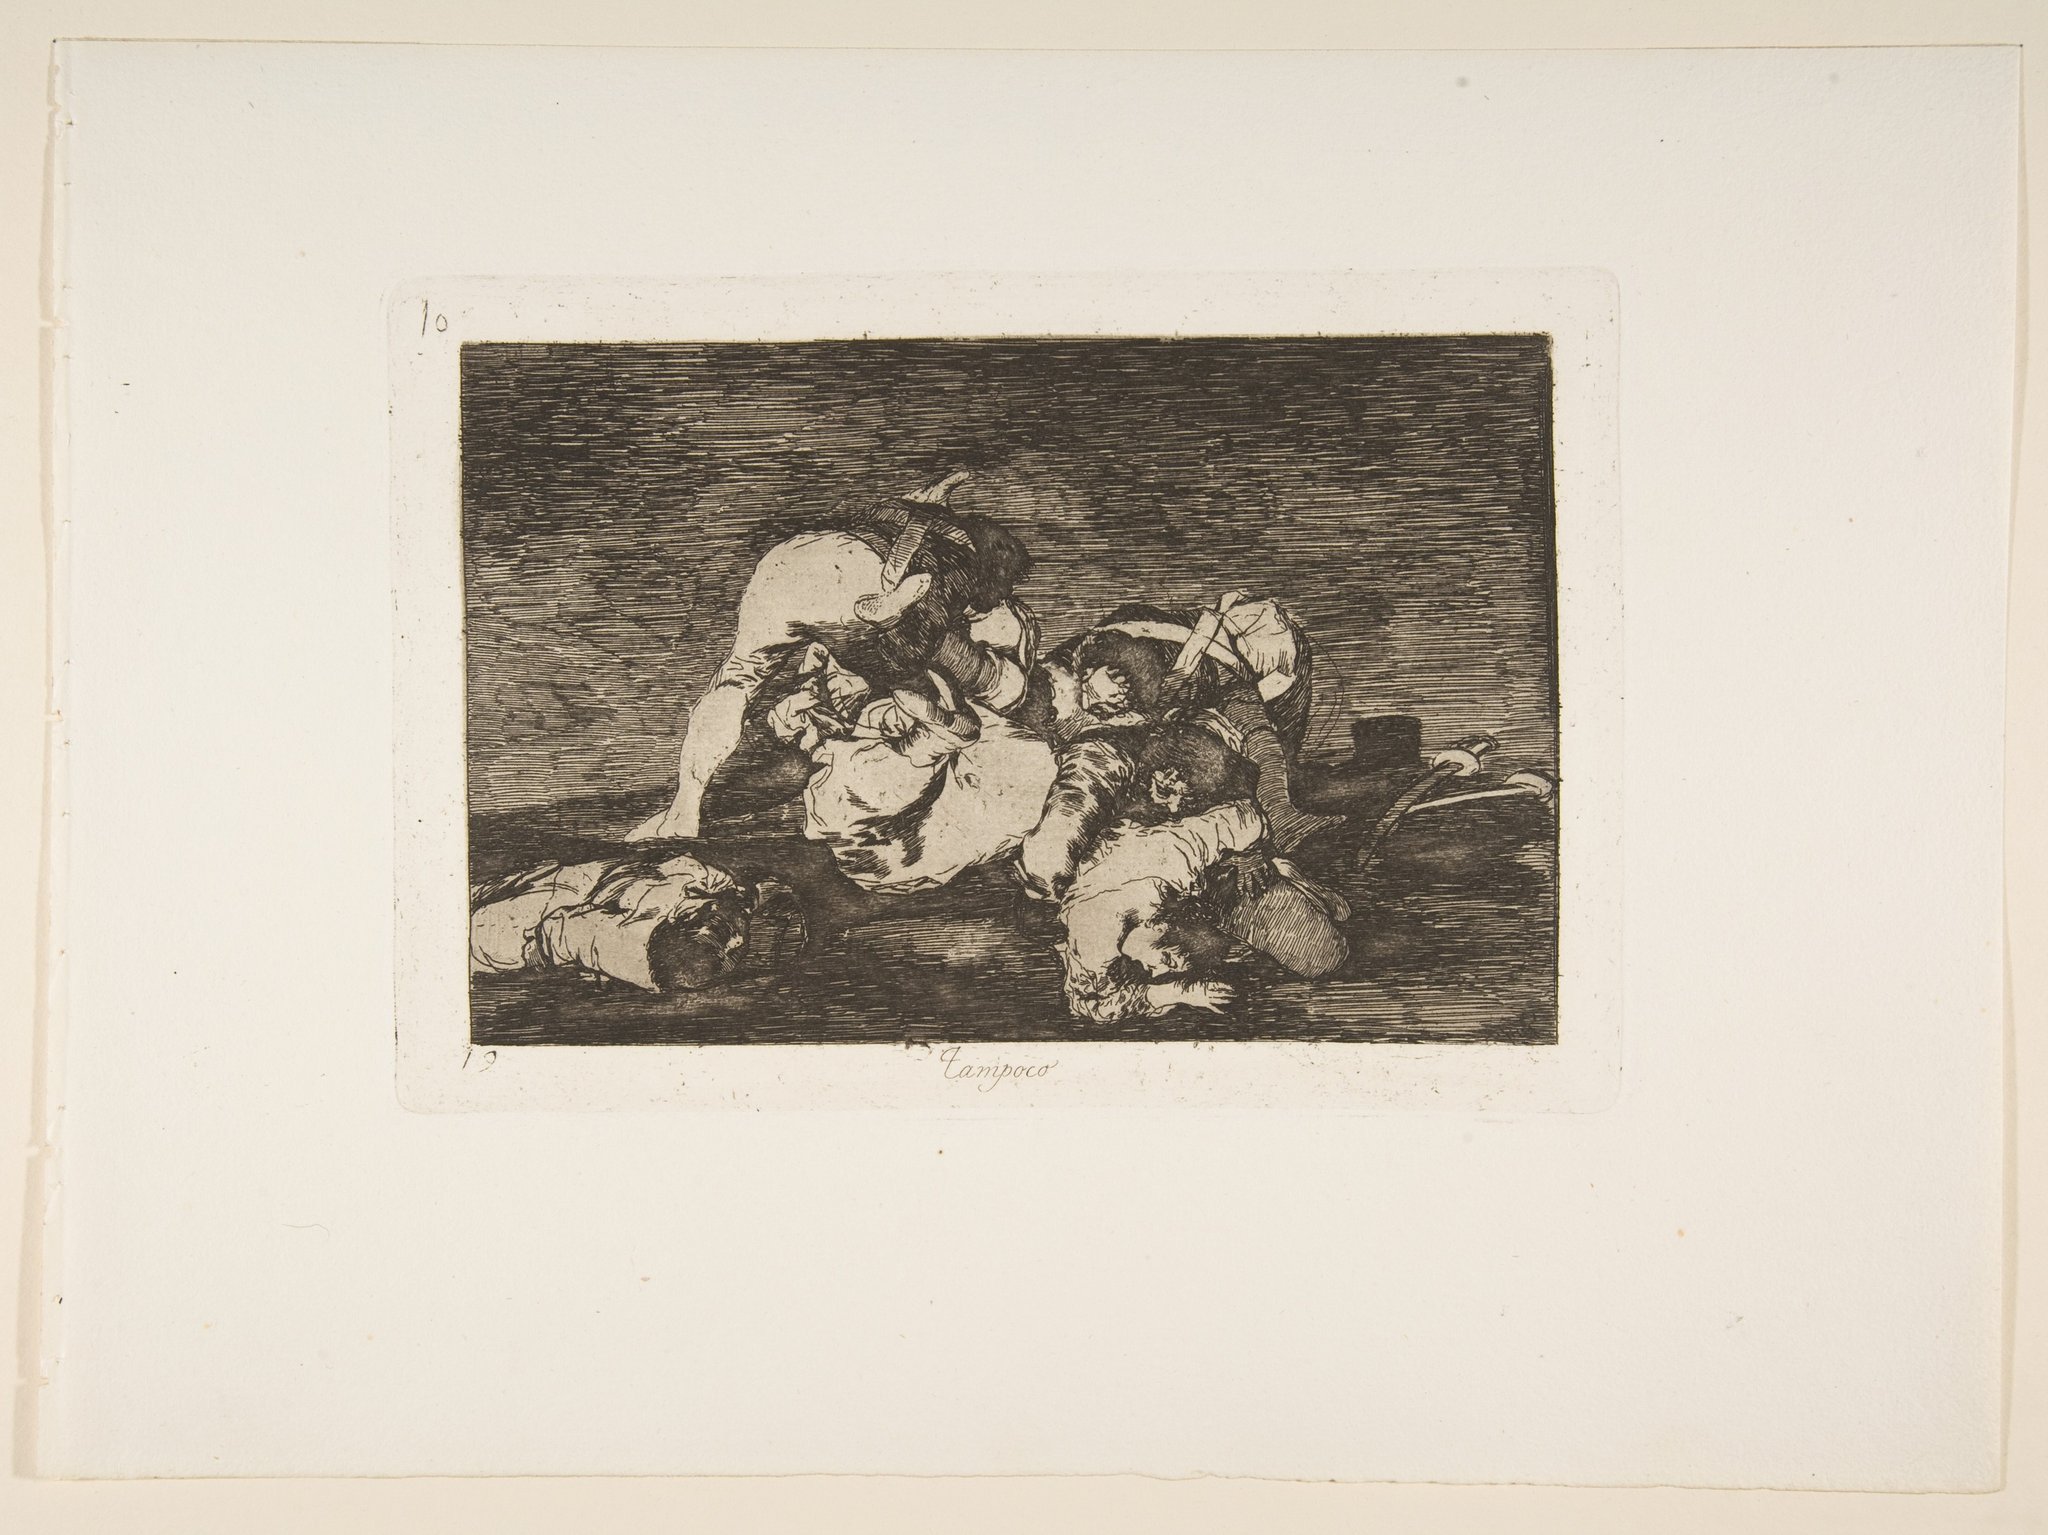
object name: print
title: Plate 10 from "The Disasters of War" (Los Desastres de la Guerra): 'Nor [do these] either' (Tampoco)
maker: goya (francisco de goya y lucientes)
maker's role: artist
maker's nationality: spanish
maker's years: 1746-1828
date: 1810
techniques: engraving, etching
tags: weapons,men